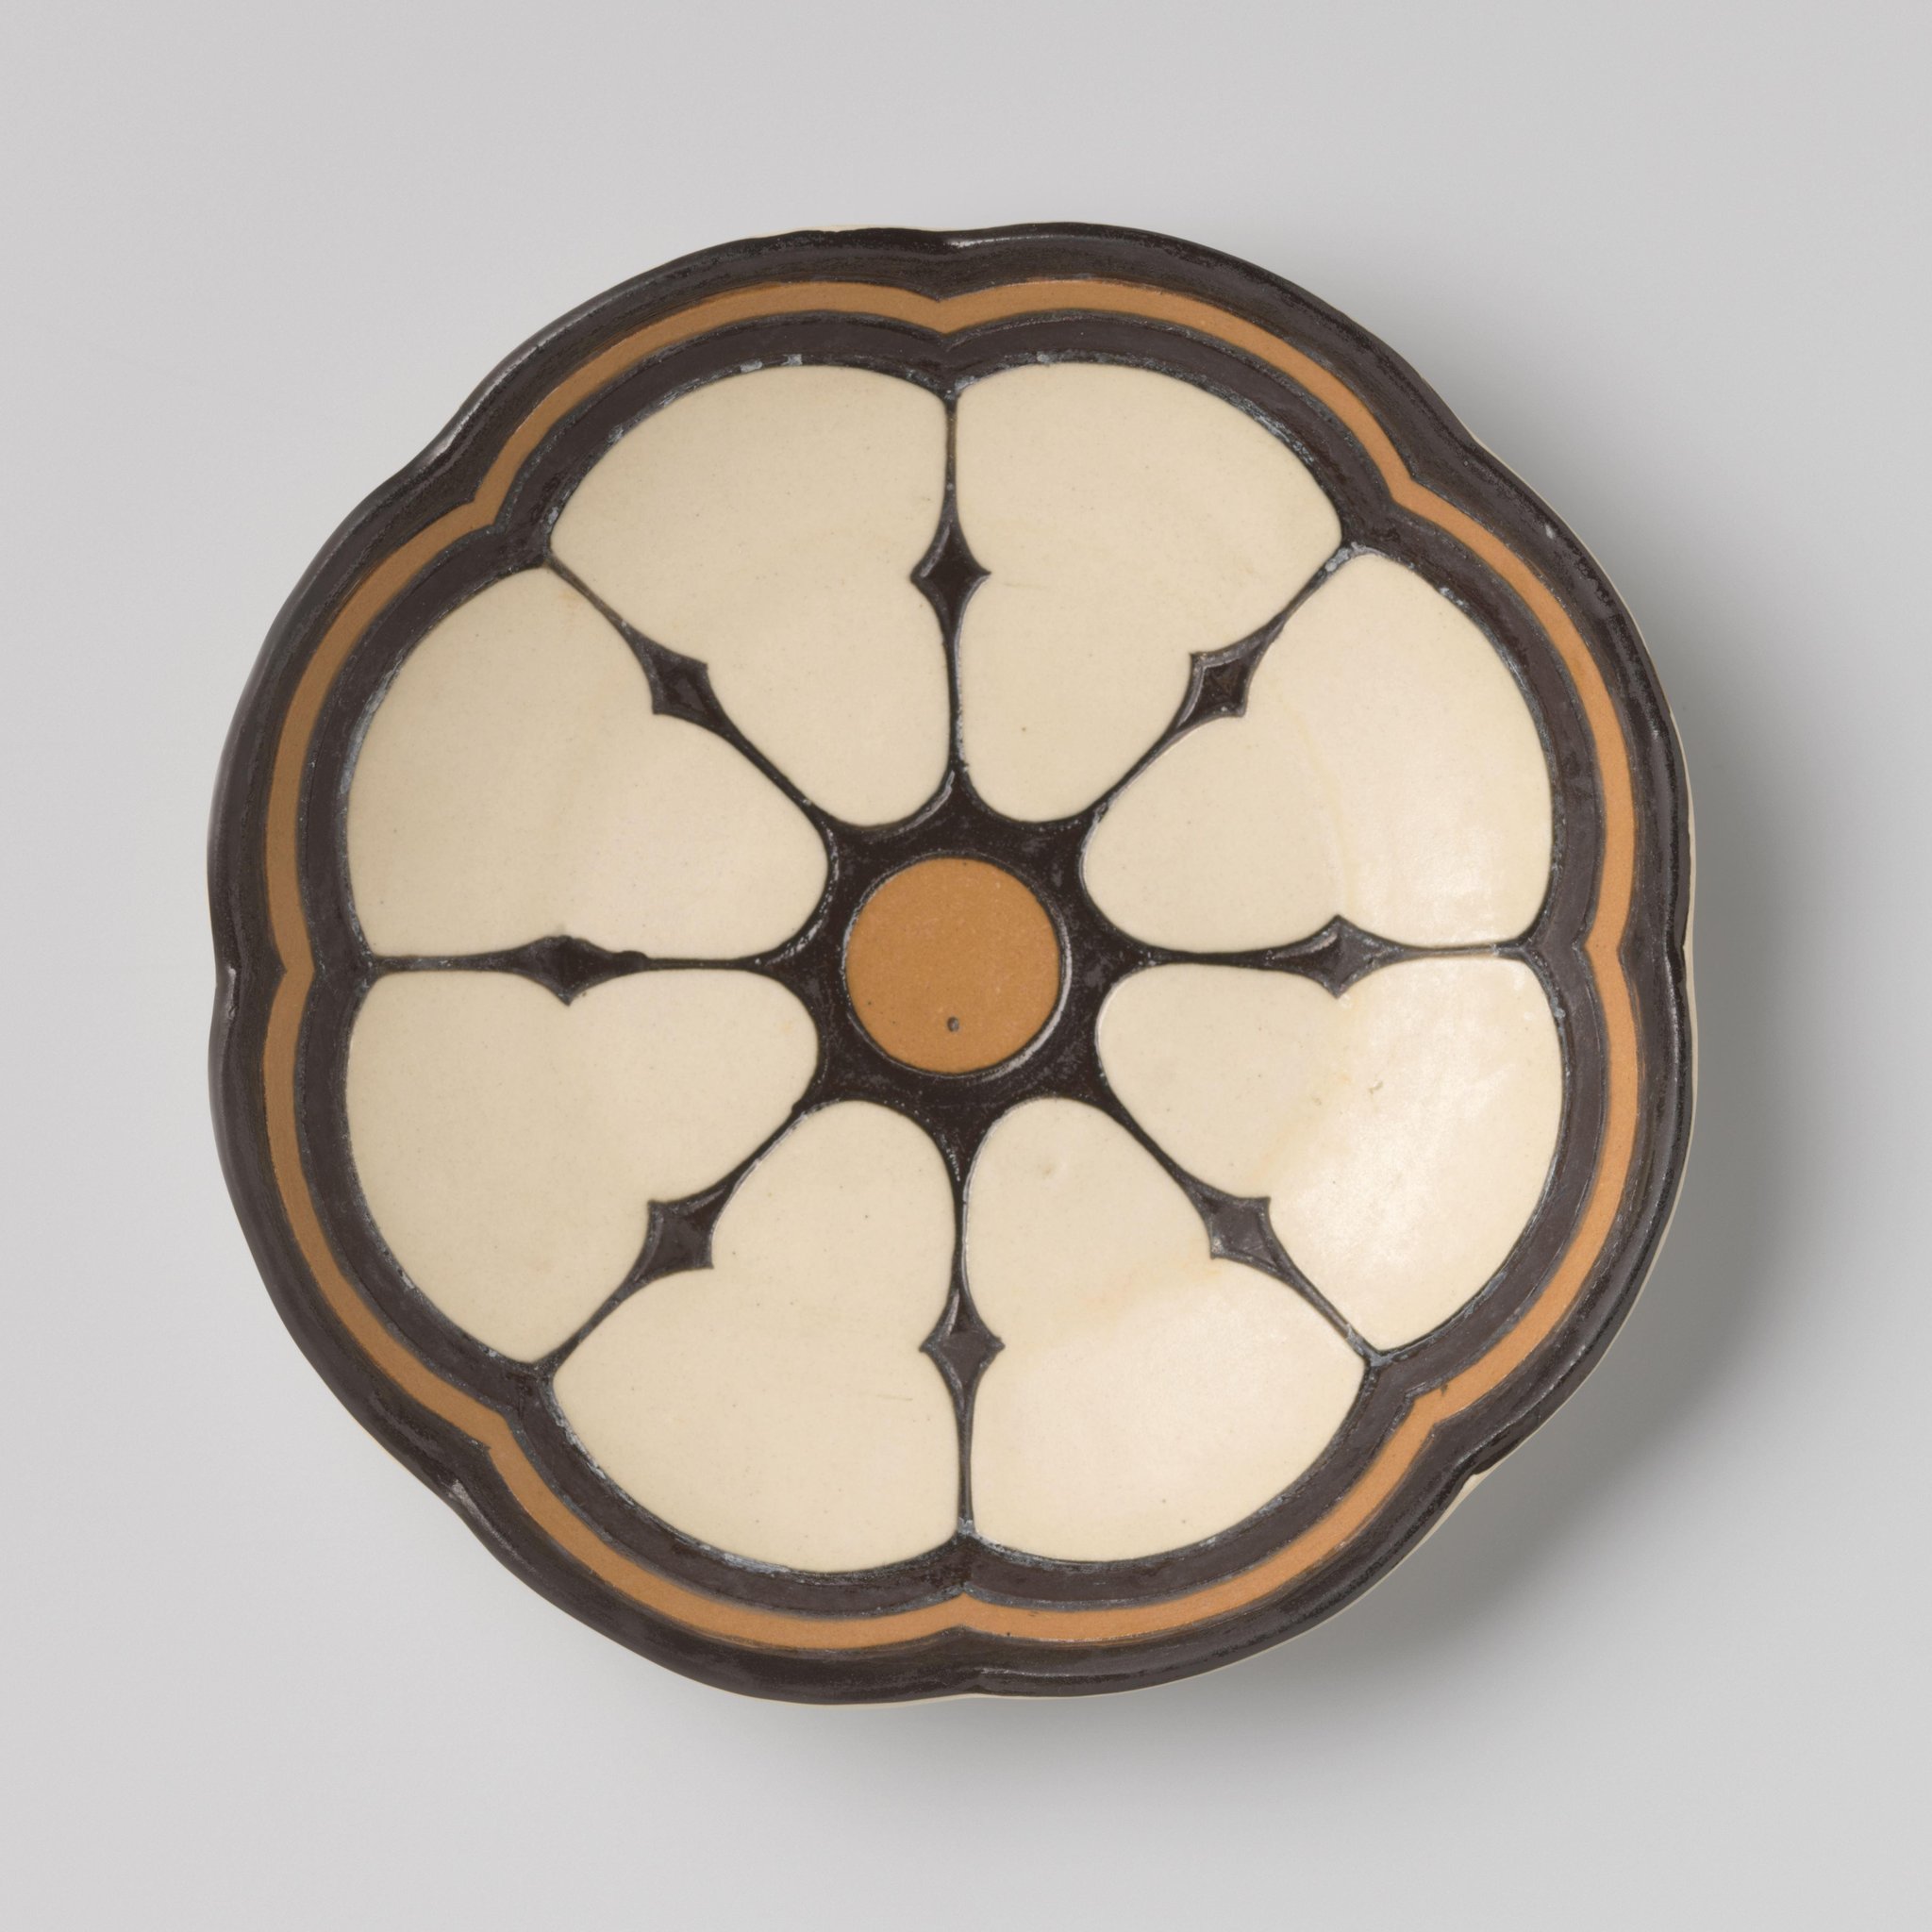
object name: platter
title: Schotel versierd met decor in zwart en bruin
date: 1906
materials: stoneware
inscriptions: mark: ‘METTLACH // VB in een naamplaat ; 23 GES.GESCH 06. en vormnr. 3060’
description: Schotel van chromolith-steengoed, versierd in zwart en bruin met een decor dat op een wiel met spaken lijkt (of een bloemkelk in reliëf).